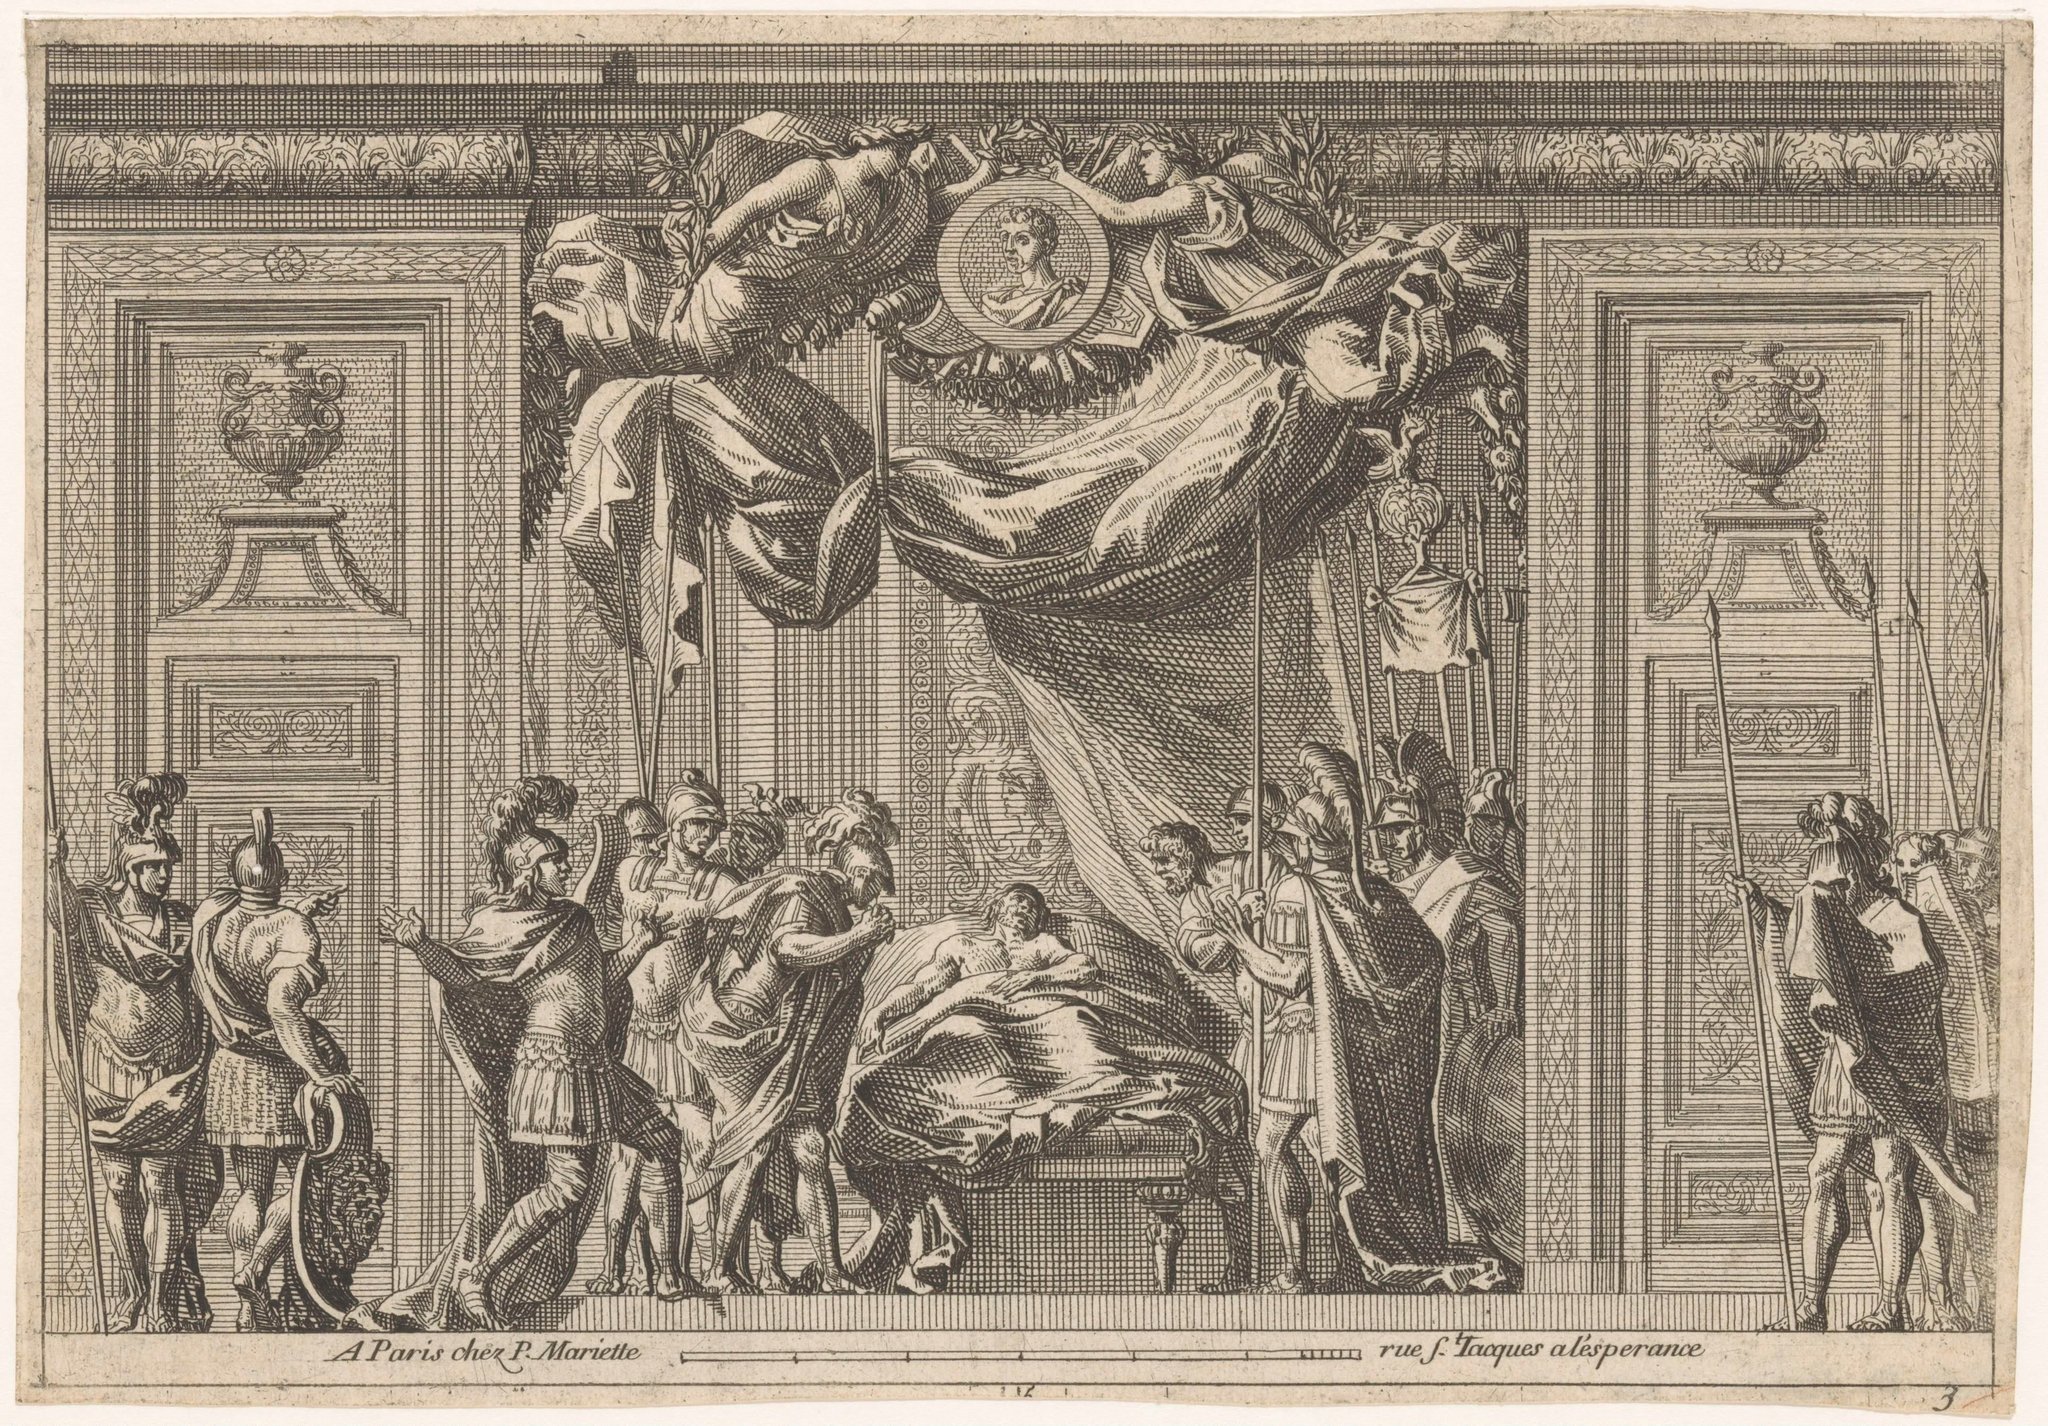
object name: print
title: Alcoves a la Romaine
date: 1657-1716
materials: paper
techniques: etching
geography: paris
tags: death of germanicus caesar: he is lying on his deathbed, his wife agrippina grieving at his bedside, and his friends swearing to avenge his death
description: Alkoof met Germanicus liggend op een bed met daarboven draperieën en engelen met lauwerkrans. Rondom staan treurende soldaten. Rechts onder 3 genummerd.